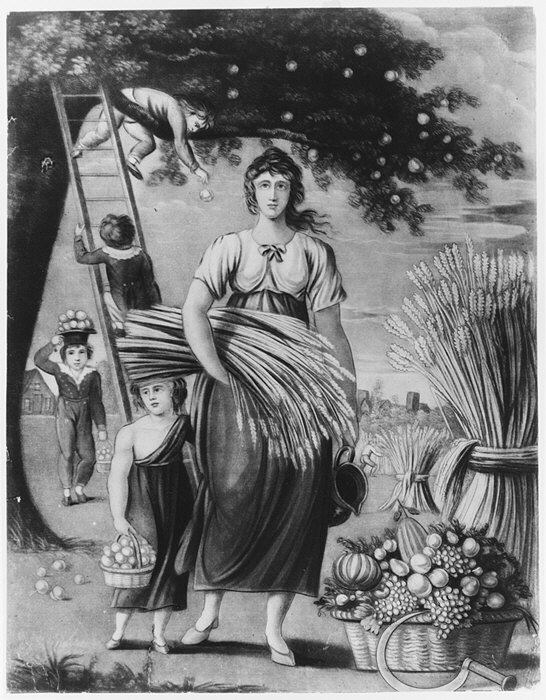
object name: print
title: Harvest Scene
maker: anonymous, british, 18th century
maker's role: artist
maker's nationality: british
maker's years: 1700-1800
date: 1701-1800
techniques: hand coloring, mezzotint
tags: boys,girls,women,agriculture,ladders